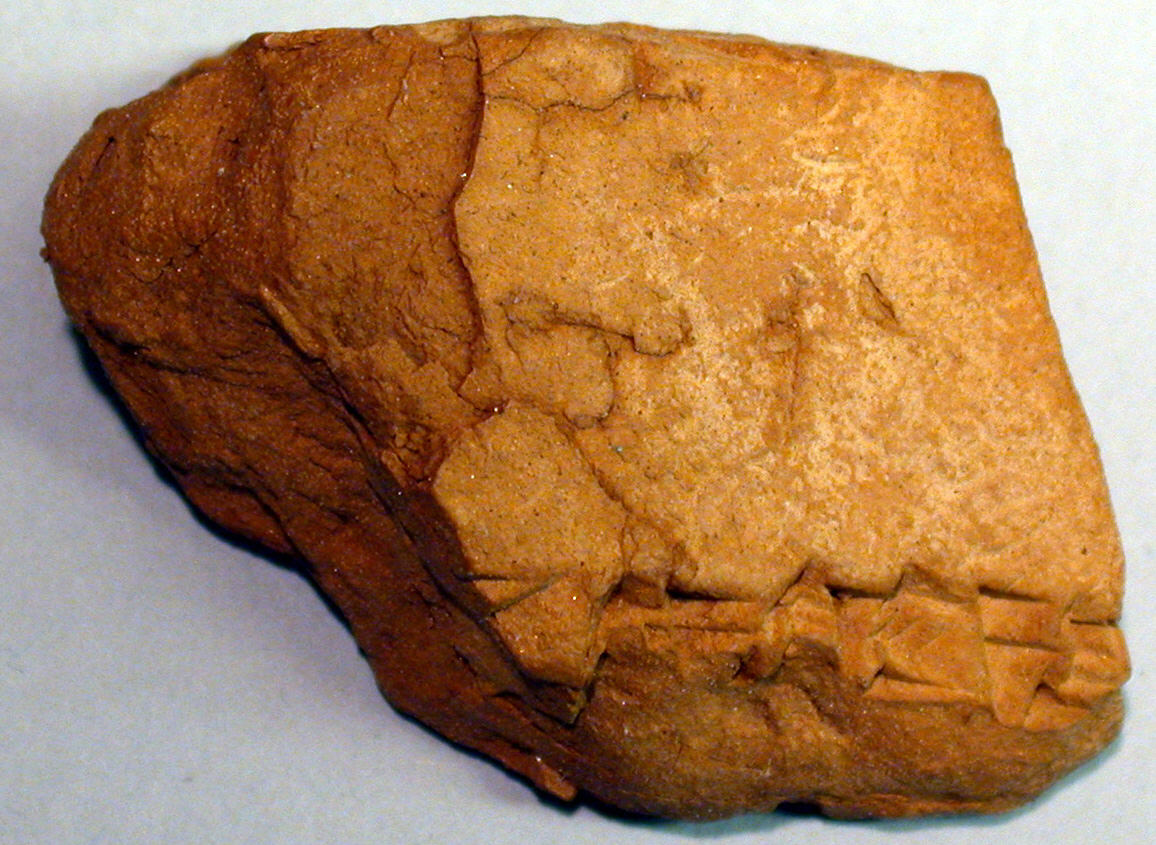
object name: cuneiform tablet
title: Cuneiform tablet: fragment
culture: achaemenid or babylonian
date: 700-301 BCE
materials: clay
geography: mesopotamia